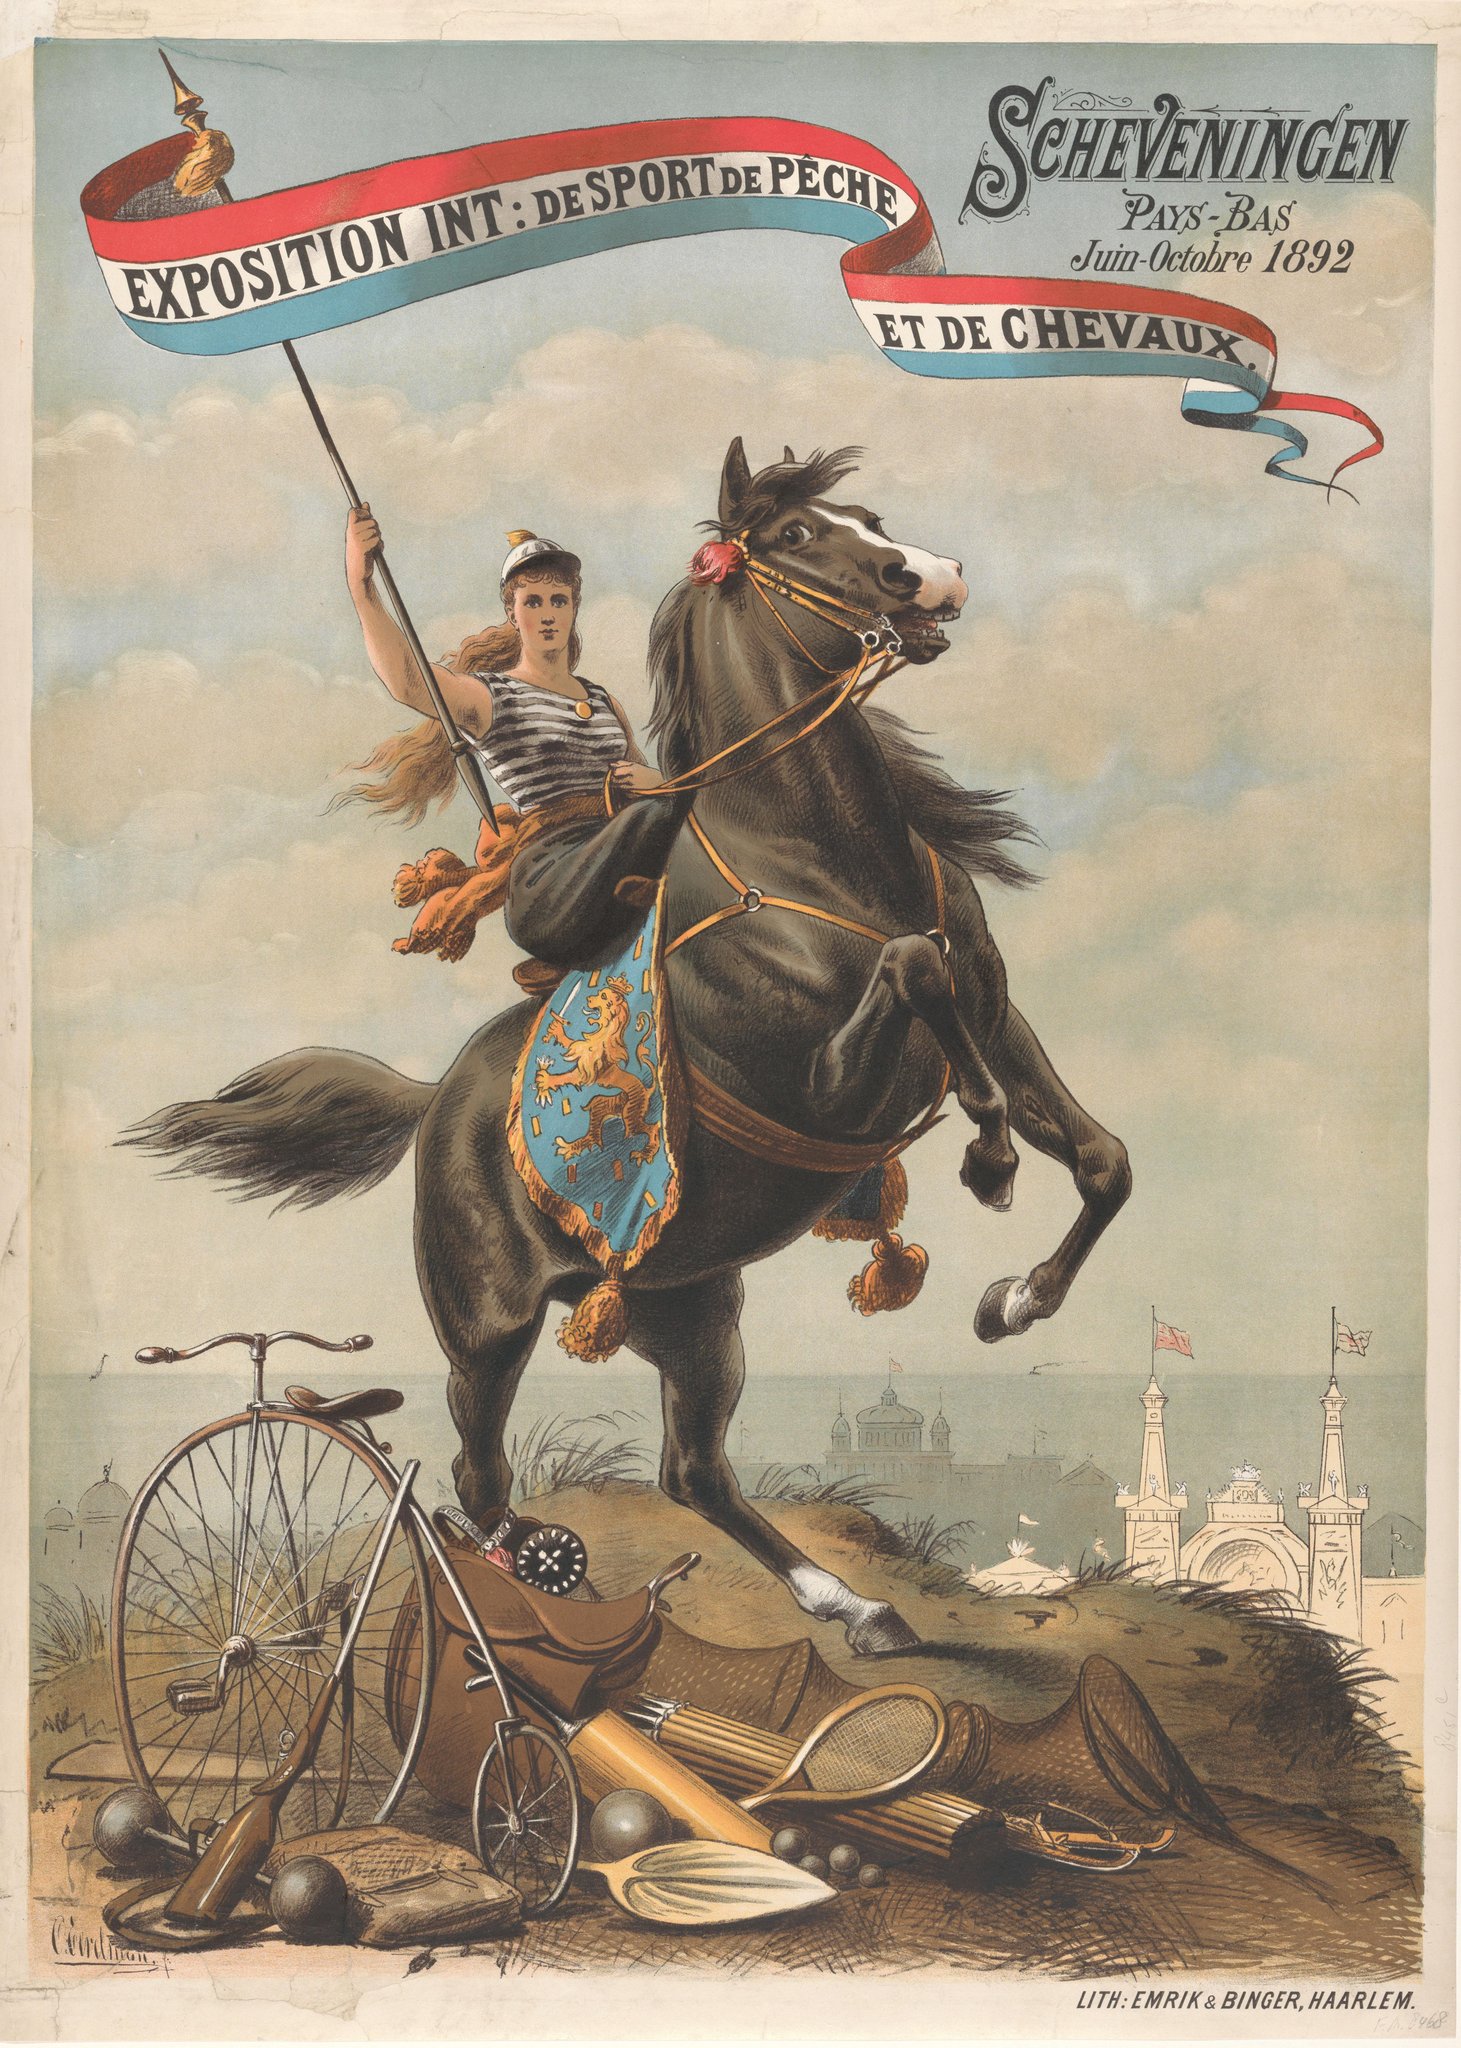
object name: print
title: Exposition Int: de Sport de Pêche et de Chevaux / Scheveningen Pays-Bas Juin-Octobre 1892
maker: otto eerelman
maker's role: draughtsman, painter, print maker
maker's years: 1839-1926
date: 1892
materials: paper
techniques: lithograph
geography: haarlem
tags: sports, etc. on land, antique types of bicycles, (annual) fair, trade fair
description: Affiche van de Internationale Sport-, Visscherij- en Paardententoonstelling in Scheveningen juni-oktober 1892. De Nederlandse Maagd met een vaandel gezeten op een steigerend paard. Op de voorgrond attributen van de paardensport en andere sporten, een fiets en een palingfuik. Op de achtergrond het Kurhaus en rechts het tentoonstellingsgebouw op het toenmalige Gevers Deynootplein.